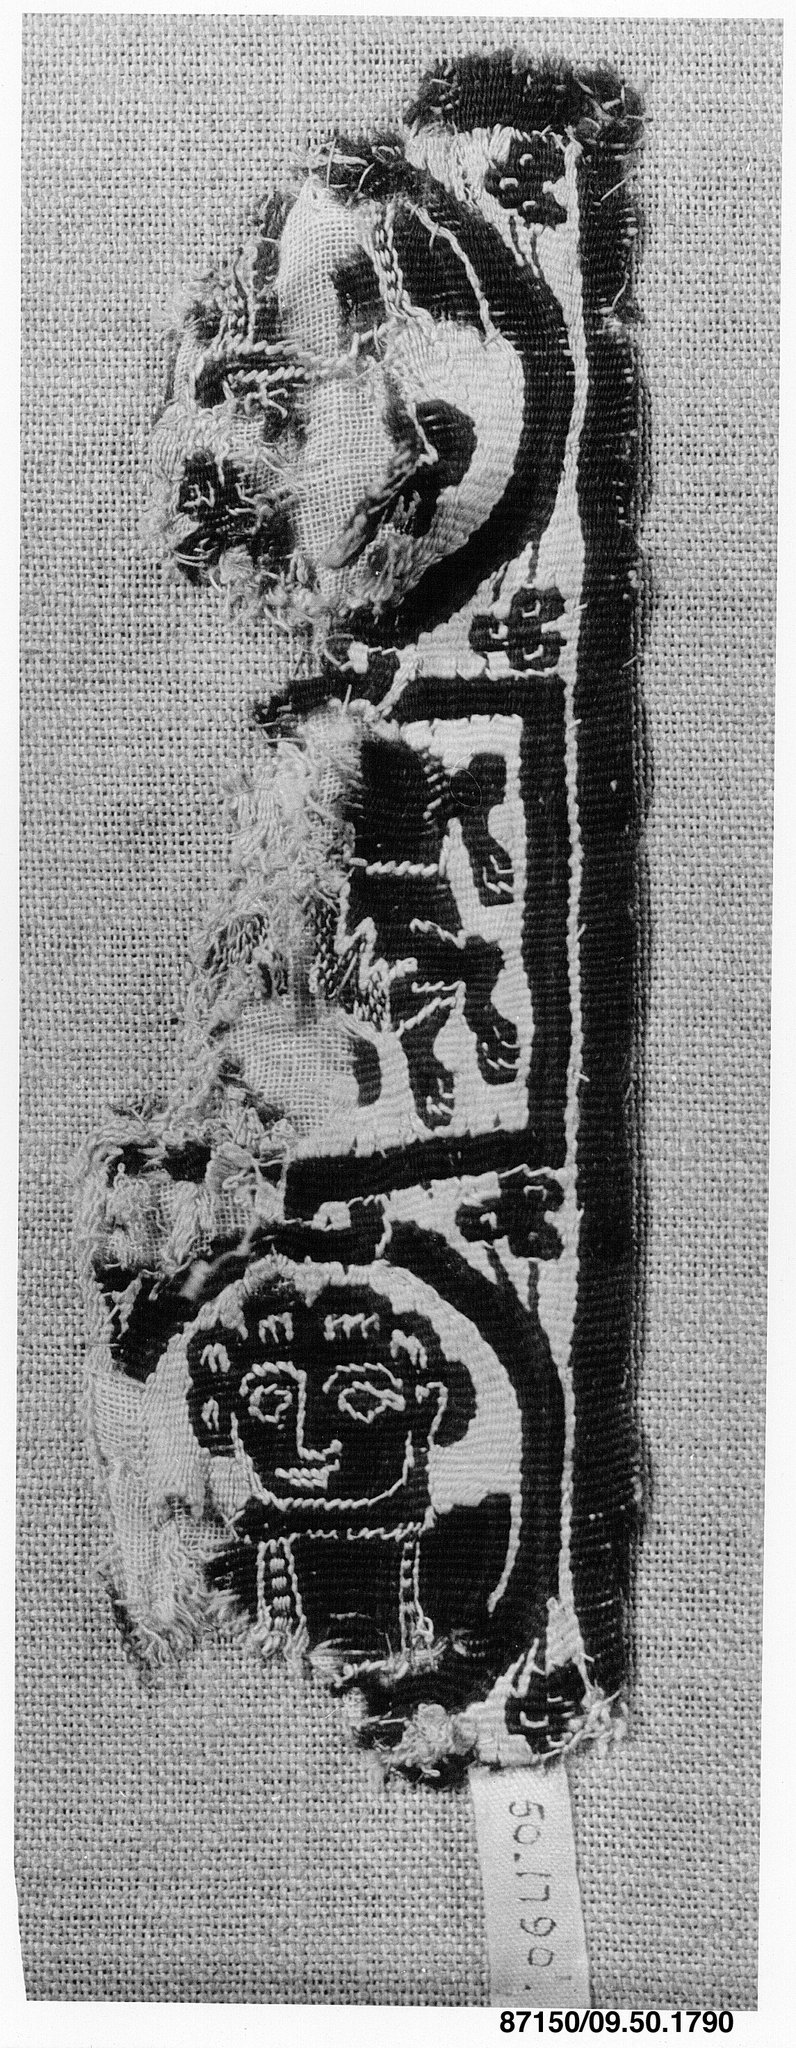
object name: textile fragment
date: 301-500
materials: linen, wool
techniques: weave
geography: egypt